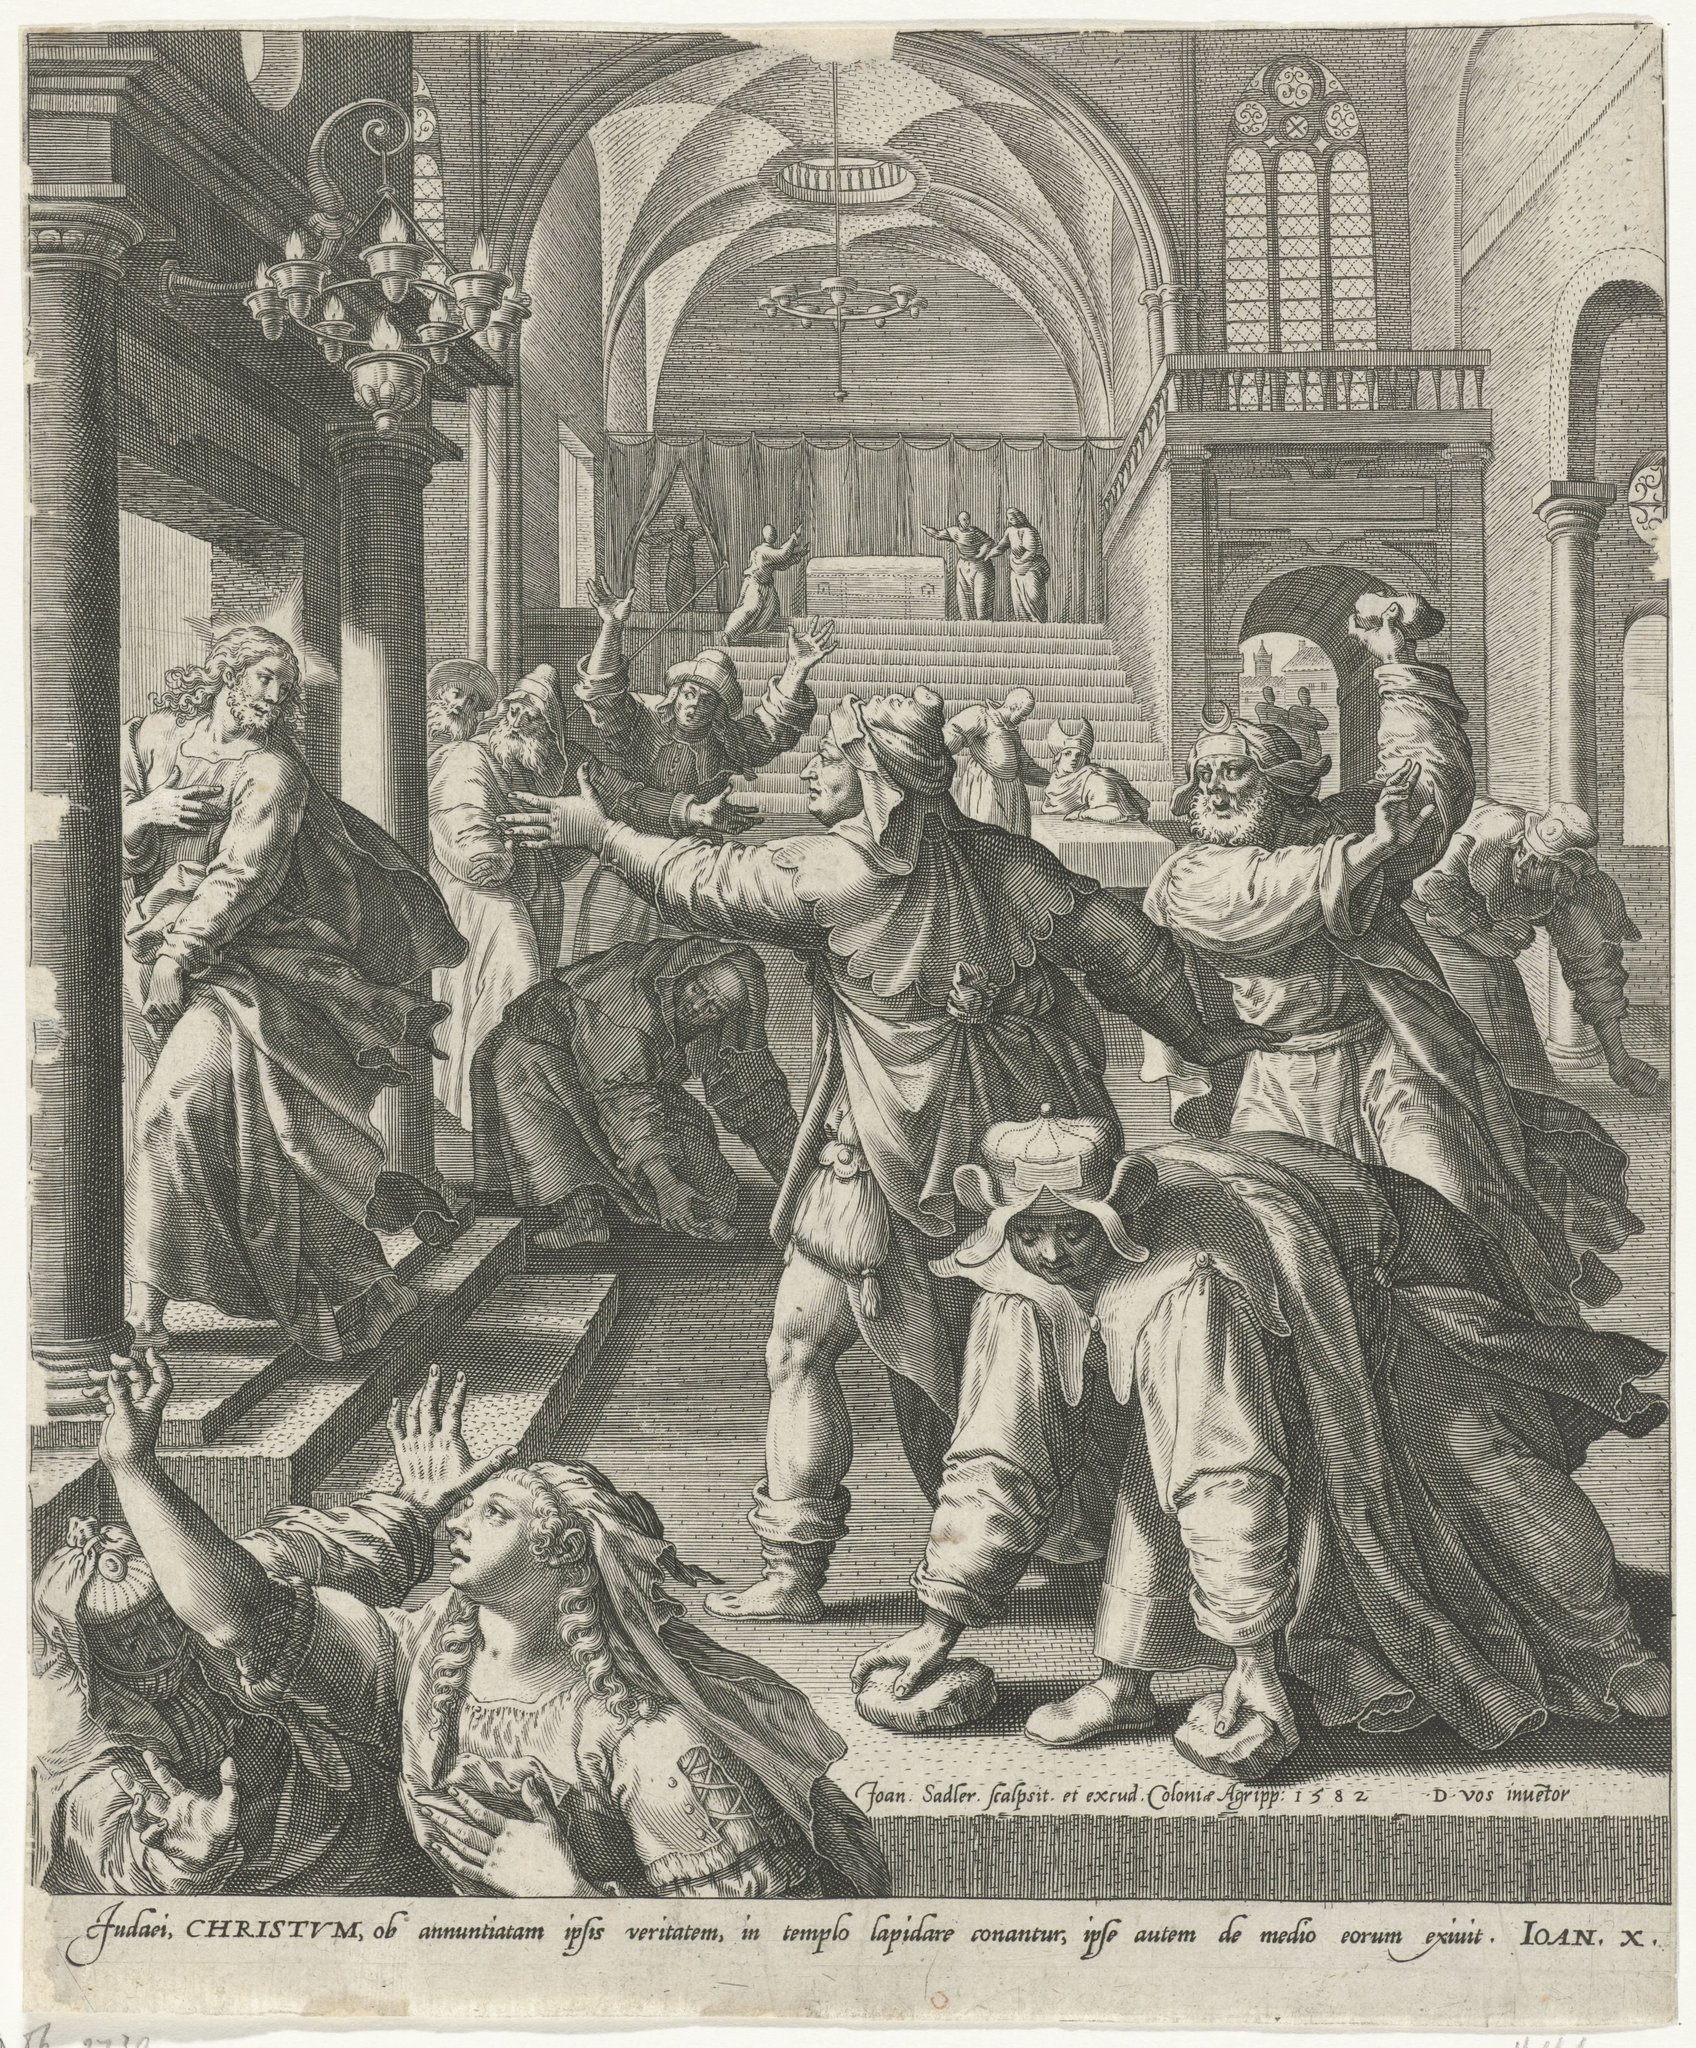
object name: print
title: Steniging van Christus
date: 1582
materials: paper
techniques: engraving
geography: cologne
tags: attempts to stone christ (john 8:59, 10:31-33)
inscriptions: collector's mark: Lugt 2228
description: Christus verlaat de tempel van Jeruzalem omdat de Joden hem willen stenigen. Op de voorgrond worden stenen opgeraapt door enkele mannen. De prent heeft een Latijns onderschrift met een Bijbeltekst (Joh. 10) en is de laatste prent van een serie van vier.